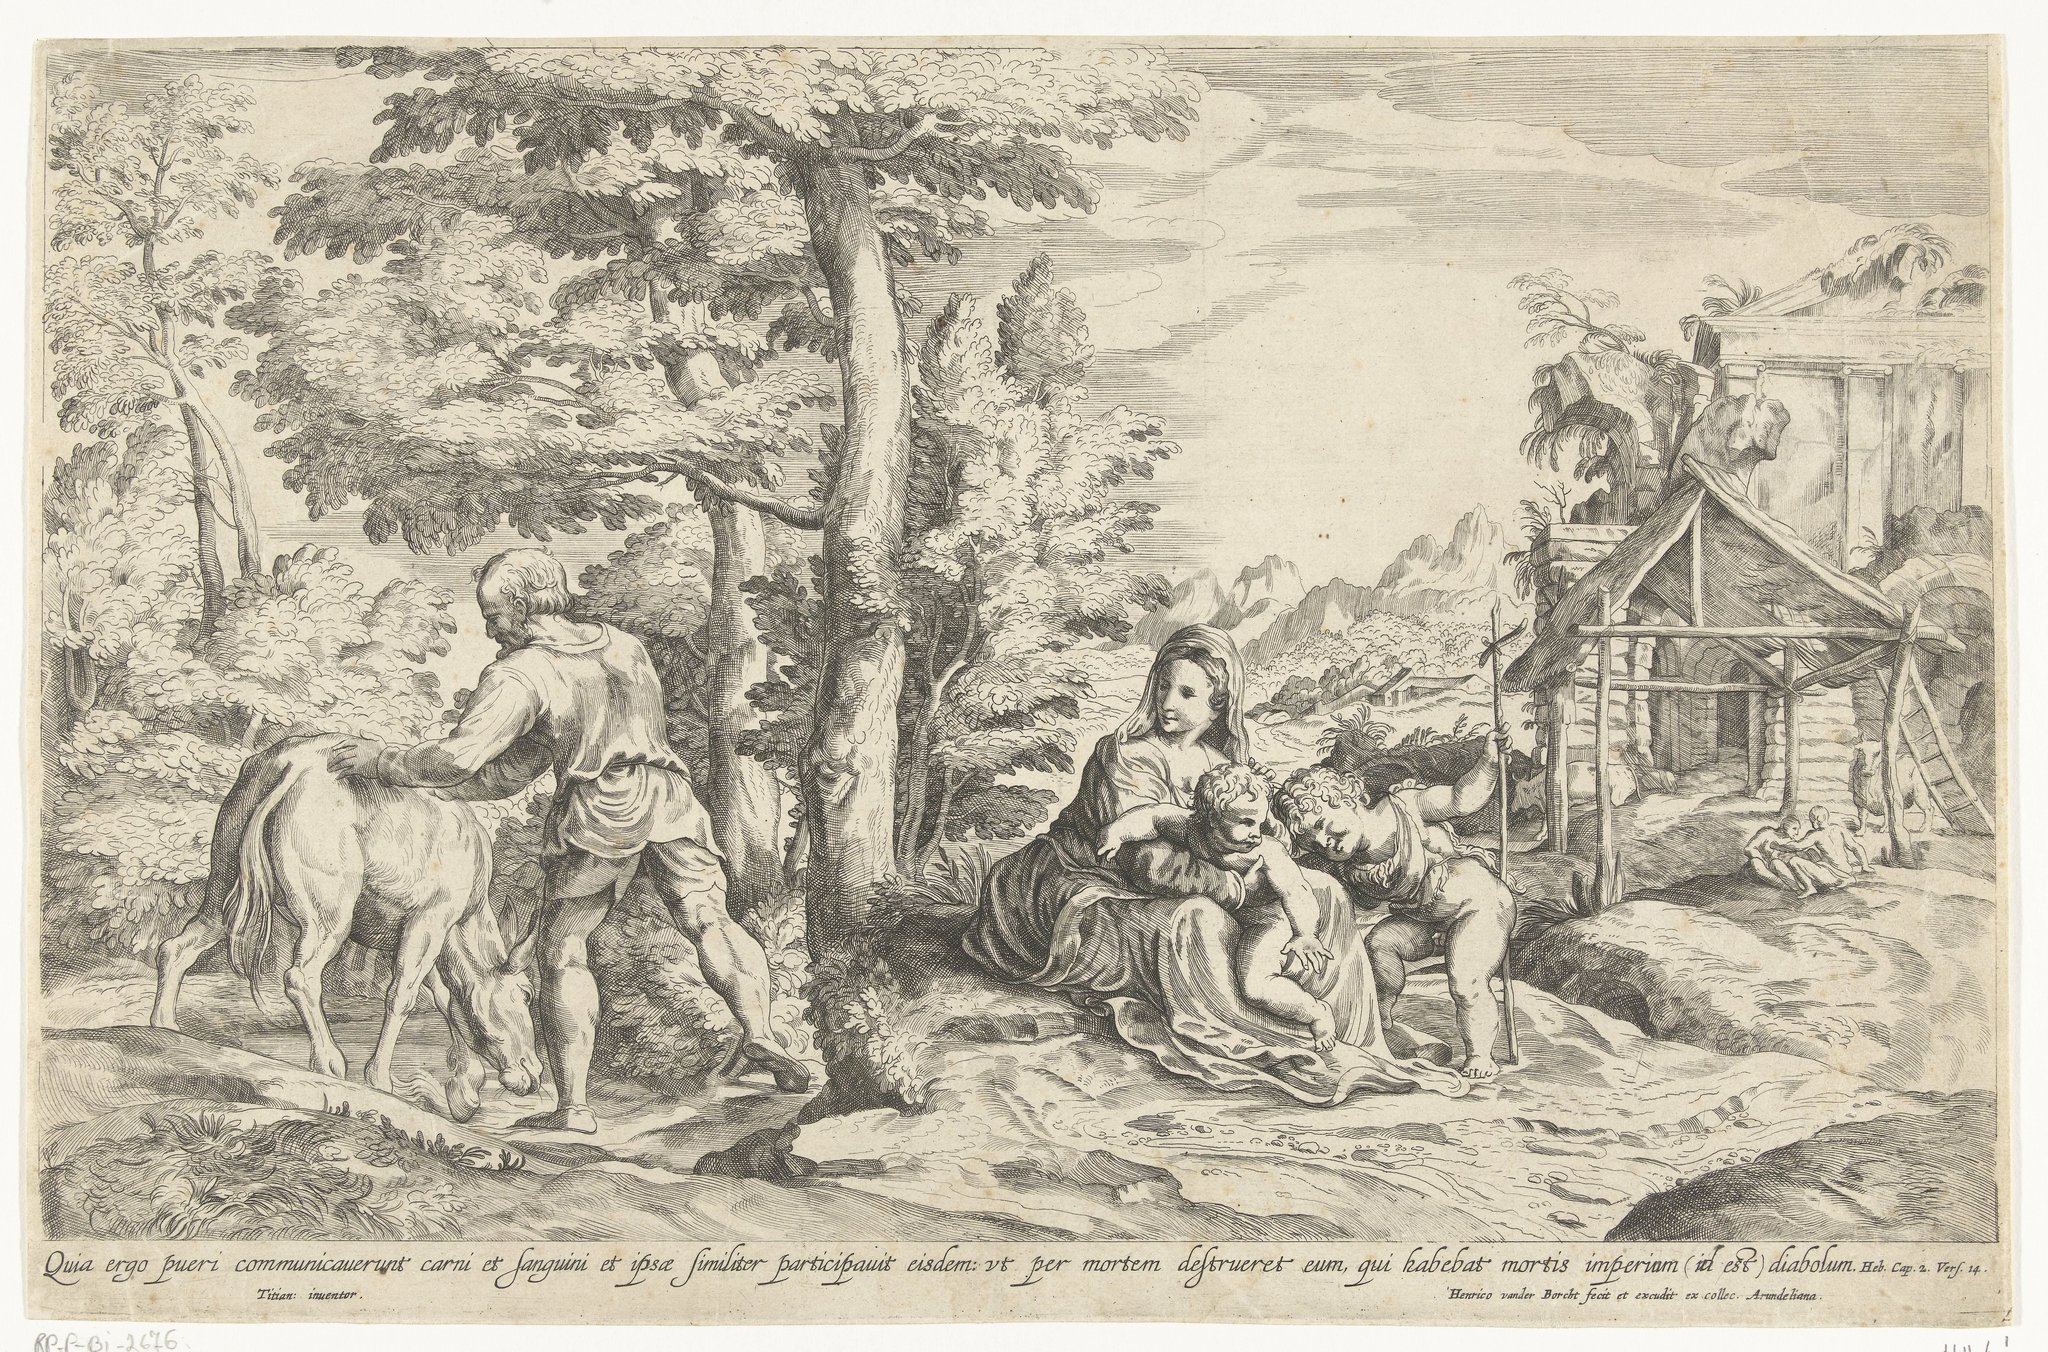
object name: print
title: Terugkeer uit Egypte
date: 1594-1660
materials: paper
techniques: etching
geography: italy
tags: landscape with ruins, mary, the christ-child and john the baptist (as child) with others, rest on the return of the holy family to israel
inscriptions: collector's mark: Lugt 240 of 1838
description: Maria rust uit. Op haar schoot speelt Christus samen met Johannes de Doper. Beiden zijn twee-drie jaar oud. Links van haar zorgt Jozef dat de ezel wat kan grazen. Op de achtergrond rechts een ruïne met twee mannen, waarschijnlijk de twee dieven die later samen met Christus gekruisigd zullen worden. De prent heeft een Latijns onderschrift met uitleg over de terugkeer uit Egypte, een apocrief verhaal.